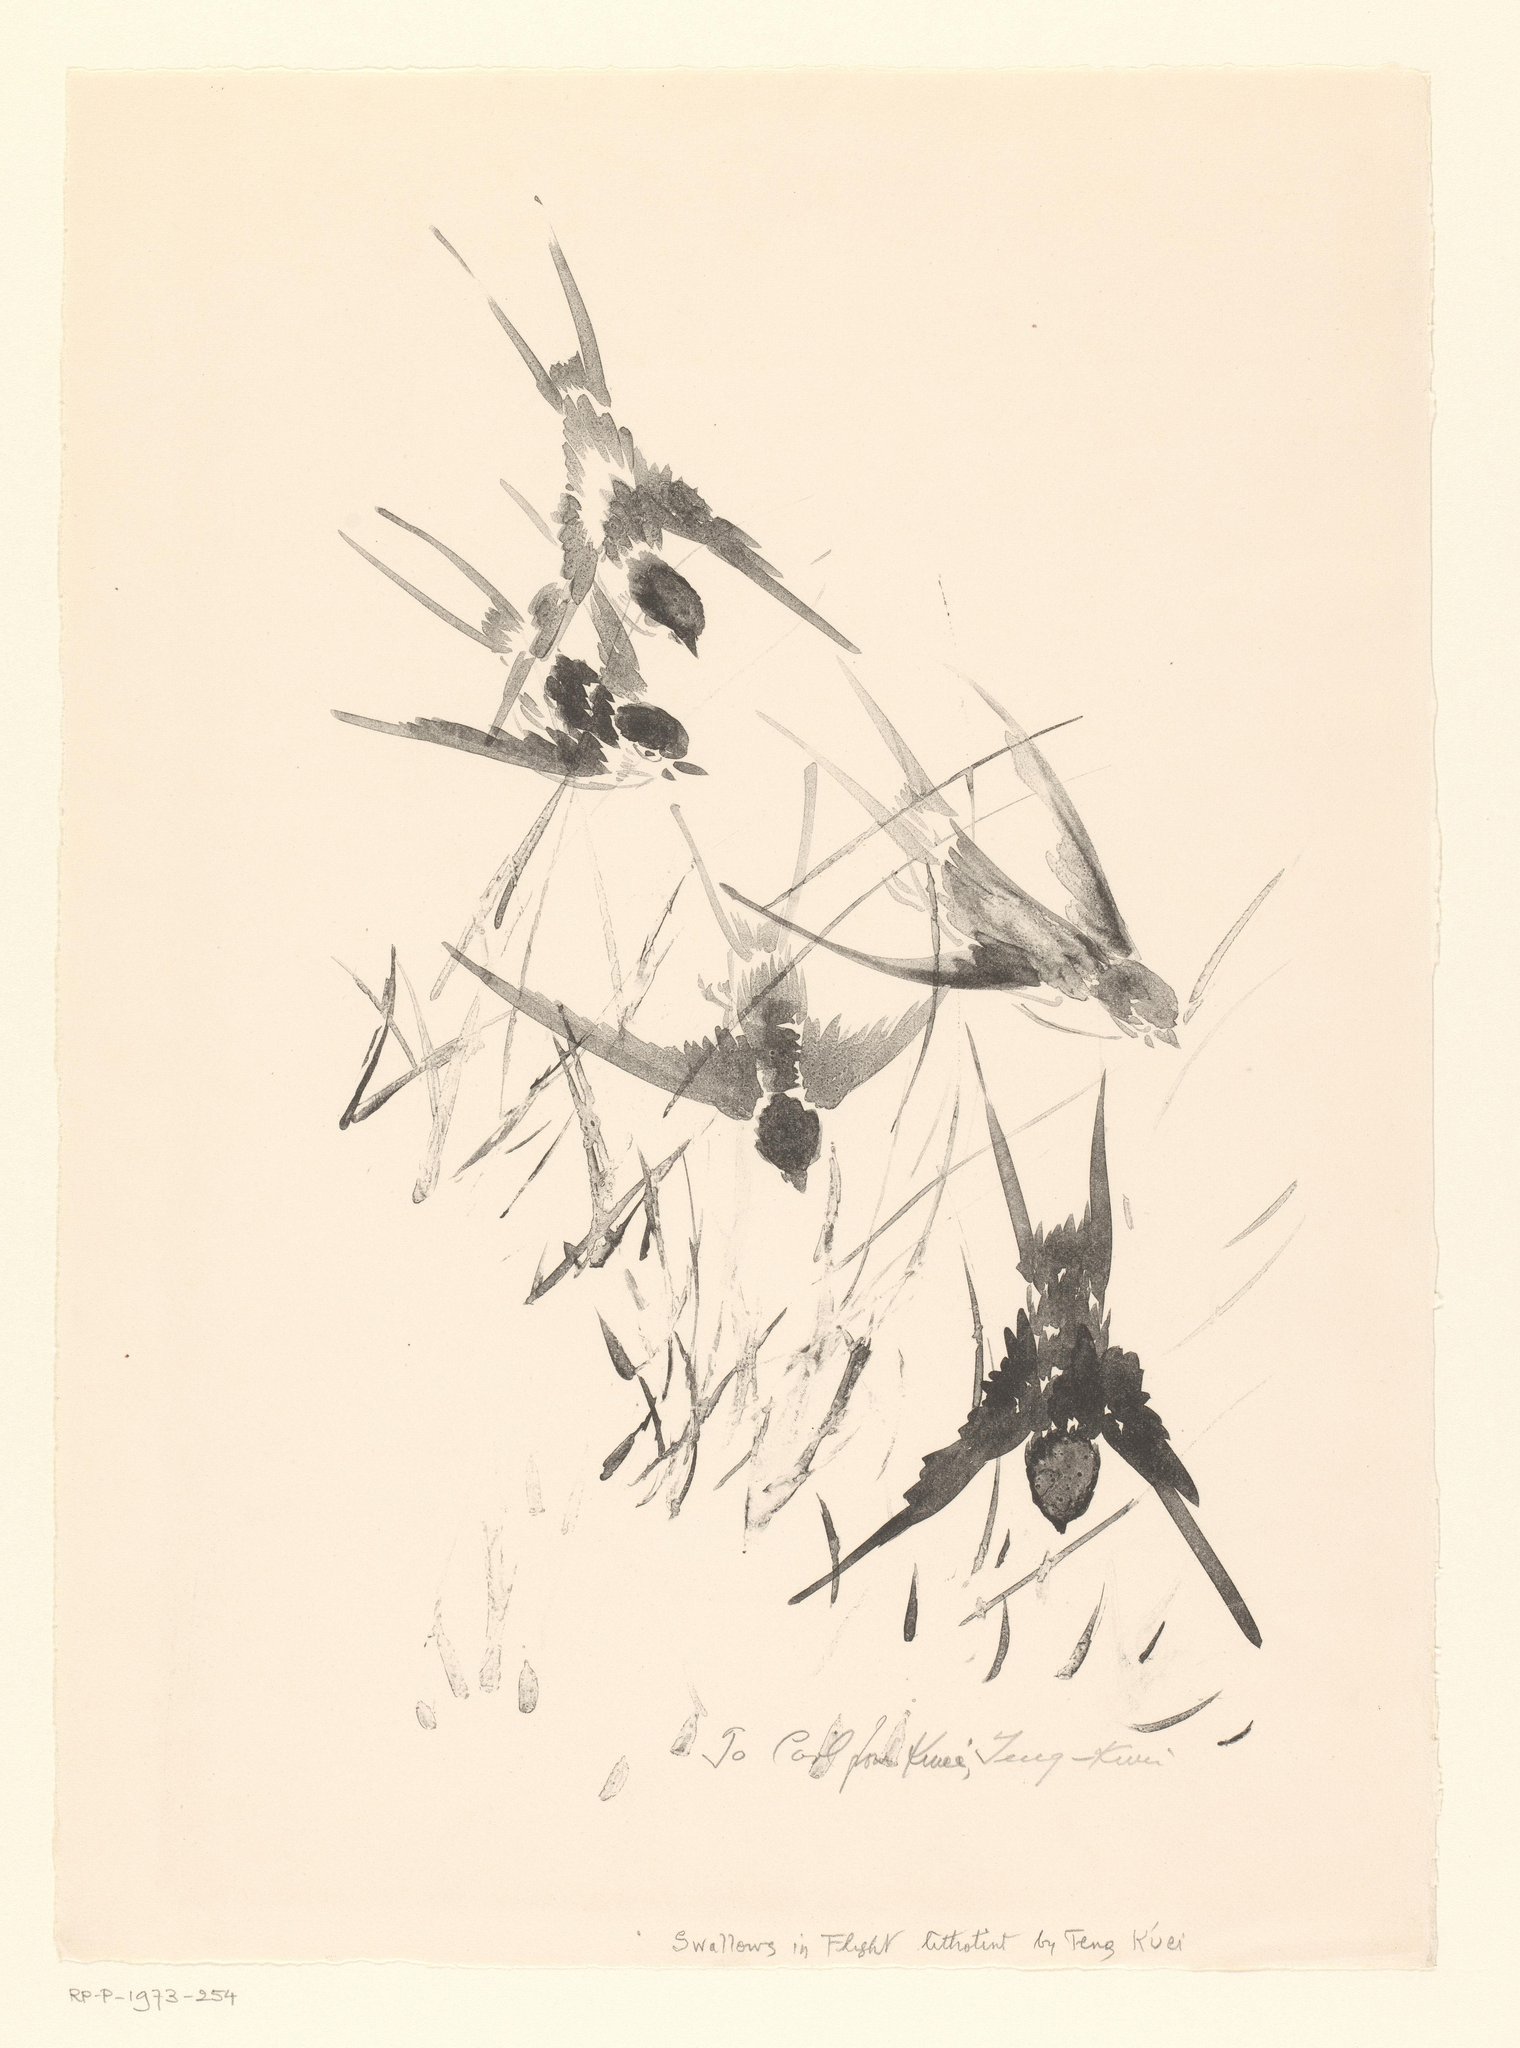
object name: print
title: Zwaluwen in hun vlucht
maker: kuei teng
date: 1930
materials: paper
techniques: lithograph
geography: china